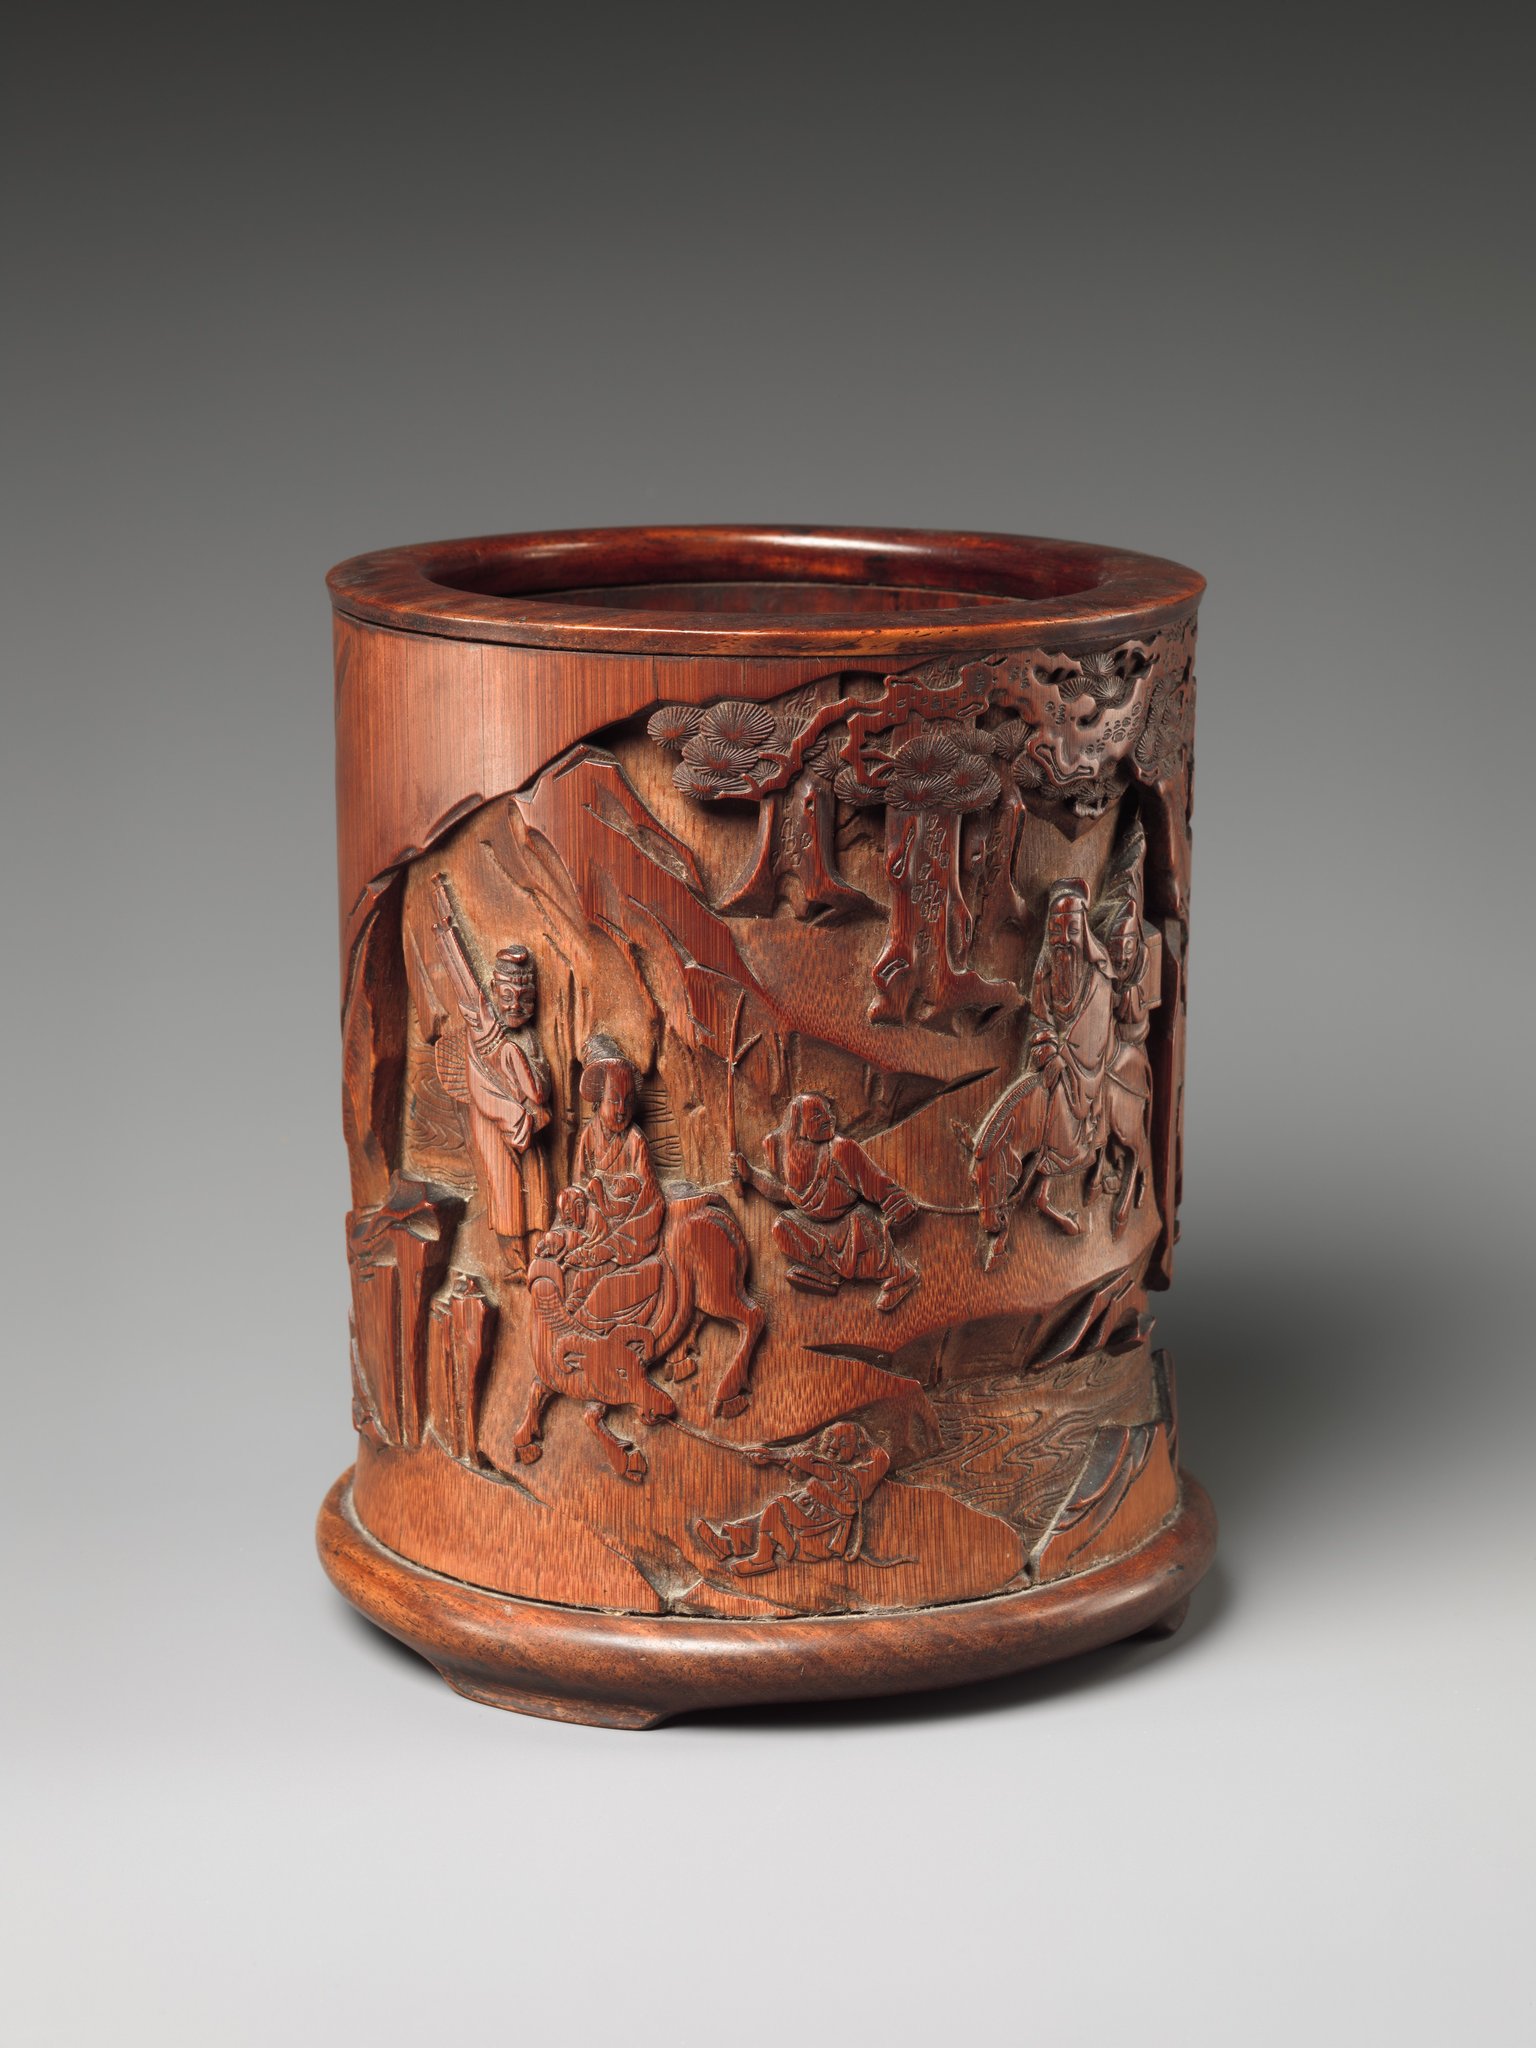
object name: brush holder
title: Brush Holder with Travelers in a Landscape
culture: chinese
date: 1867-1933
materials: bamboo, wood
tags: men,women,cats,dogs,donkeys,trees,ox